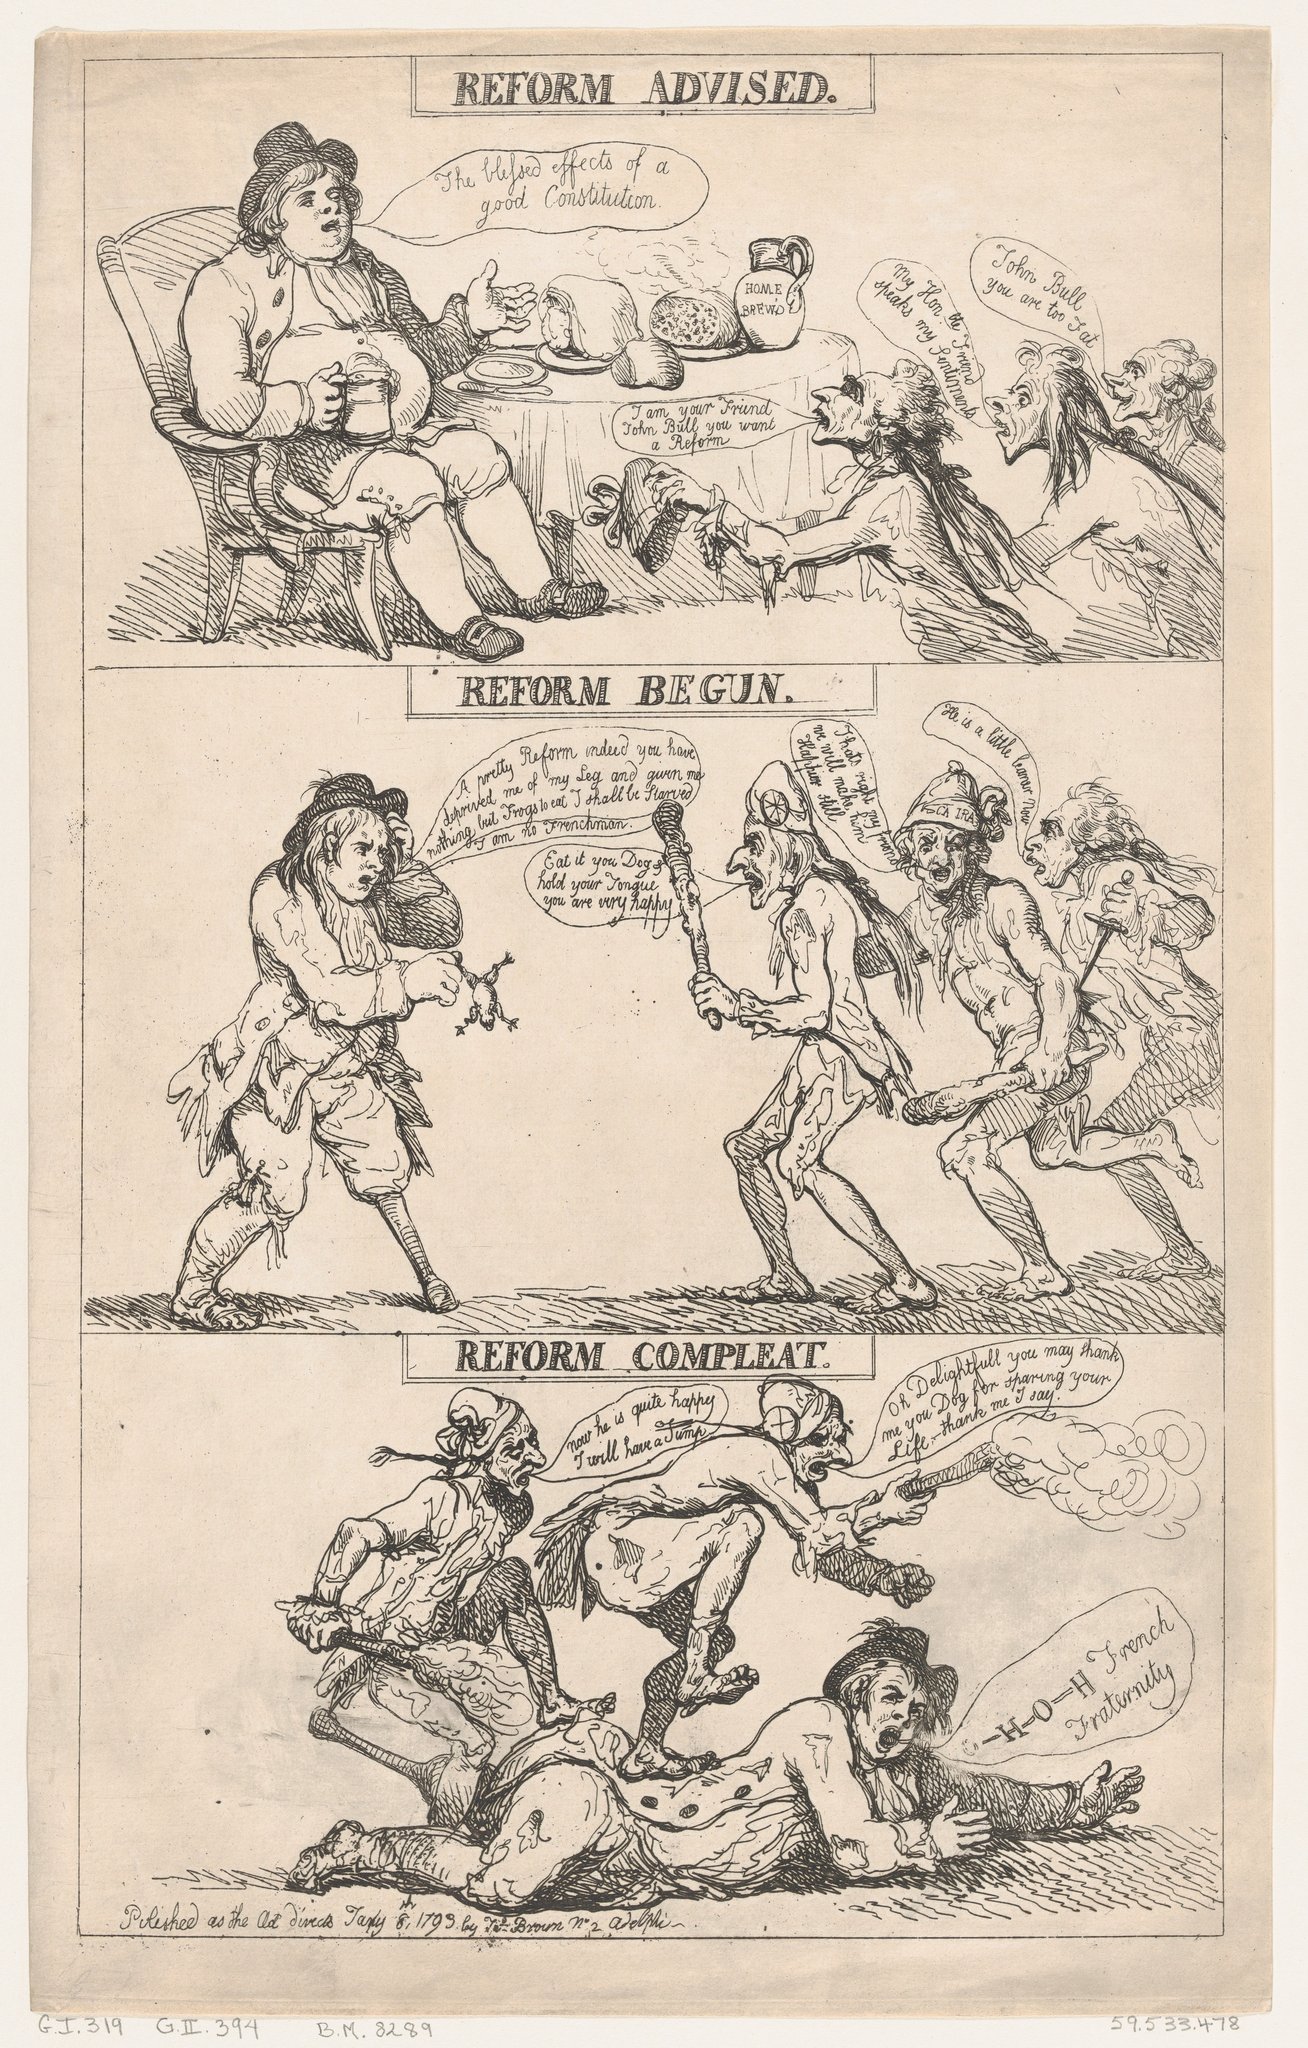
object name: print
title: Reform Advised, Reform Begun, Reform Complete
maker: thomas rowlandson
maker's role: artist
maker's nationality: british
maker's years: 1757-1827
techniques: etching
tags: satire,men